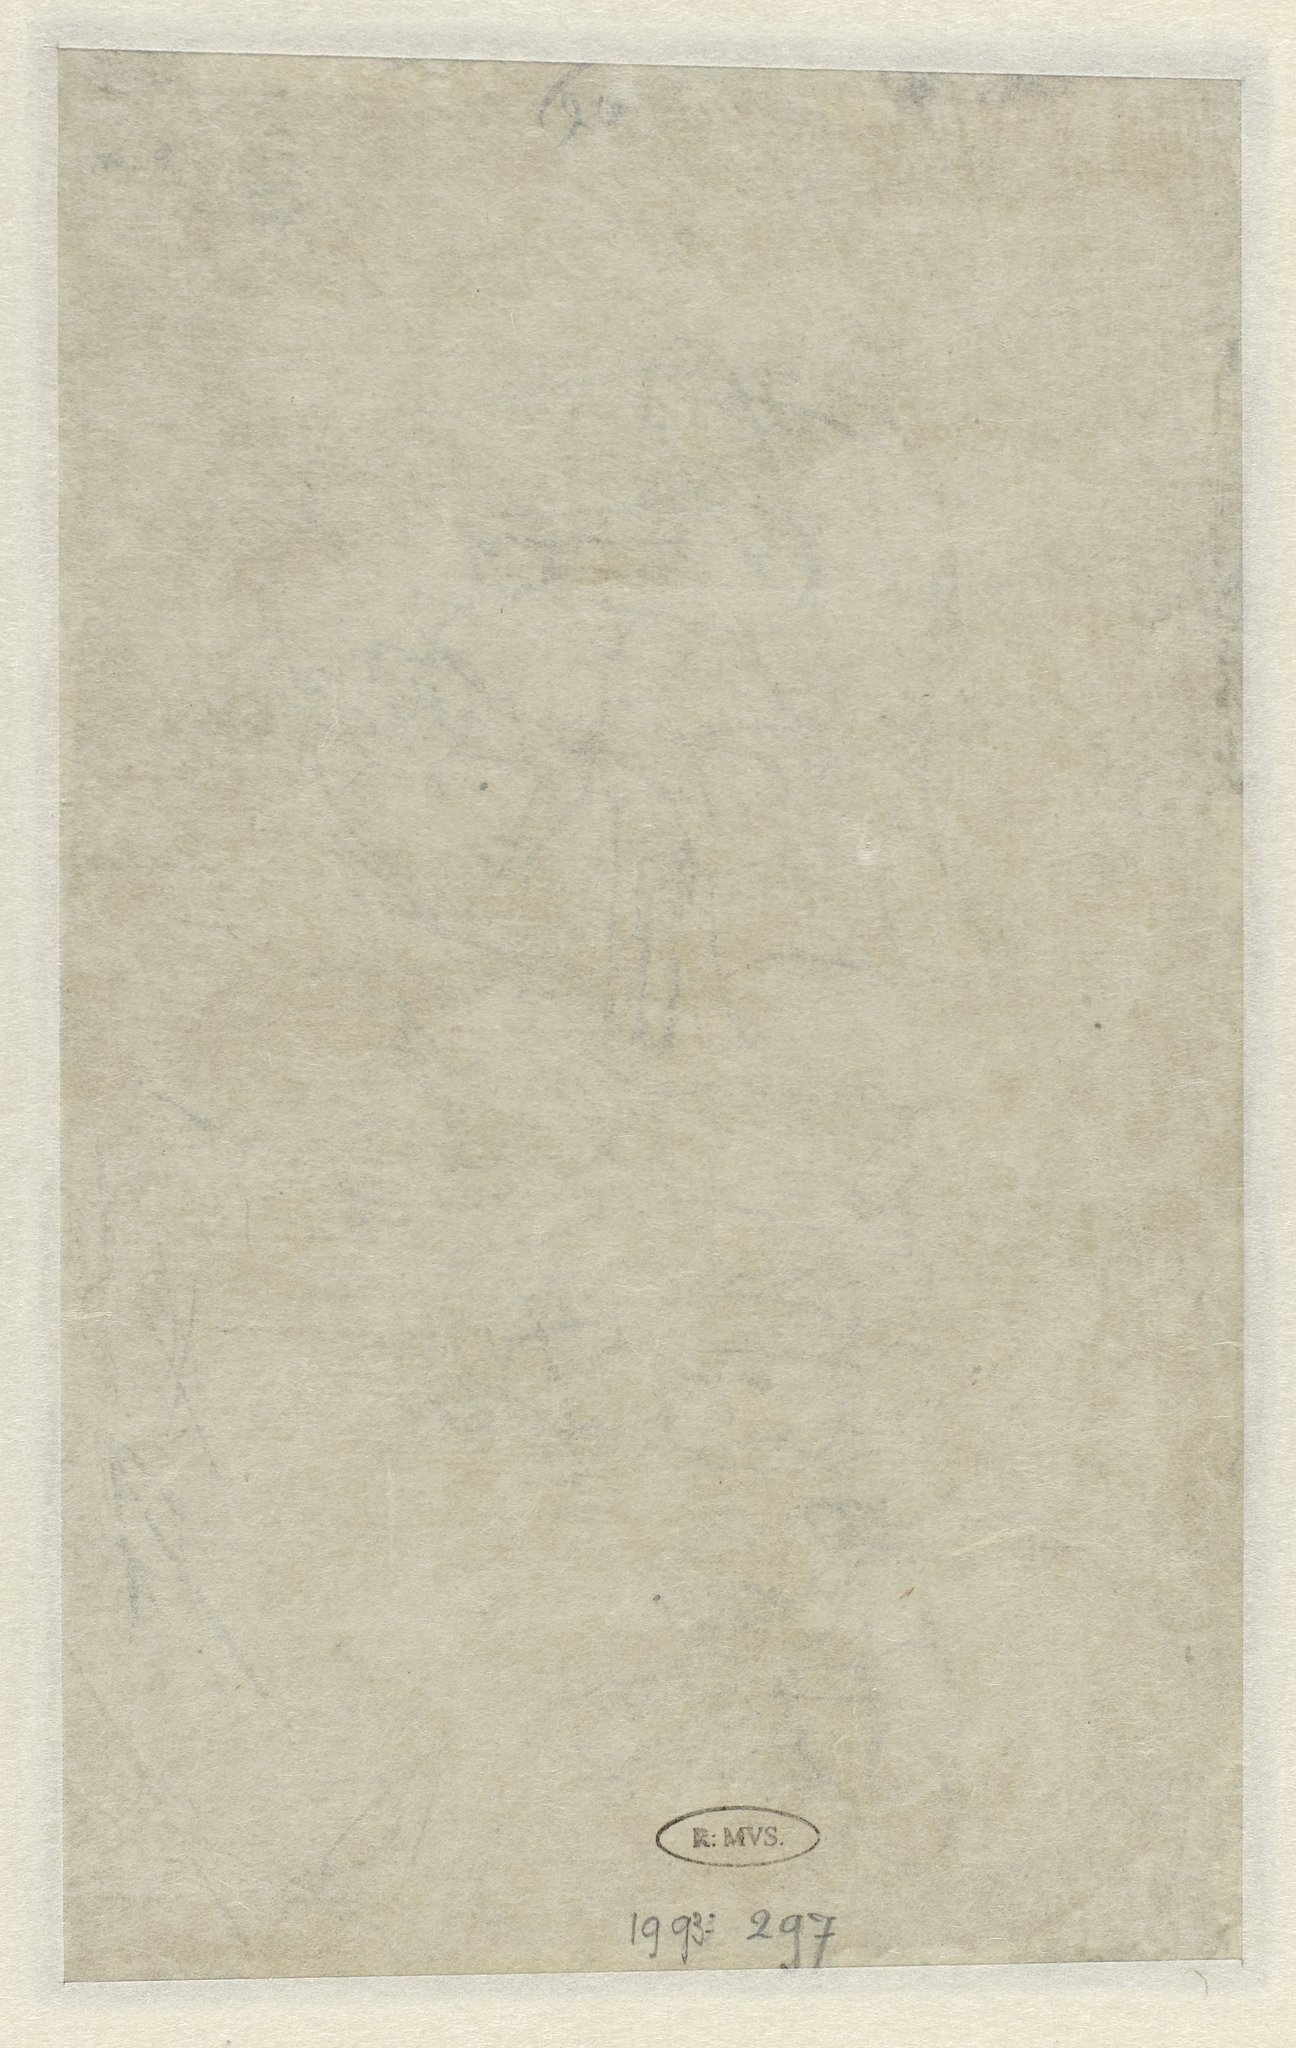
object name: drawing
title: Vorst en zijn gemalin ontvangen een groep onderdanen die met geschenken komen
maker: Anonymous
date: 1830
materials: paper, pencil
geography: kangra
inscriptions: inscription: ‘.’